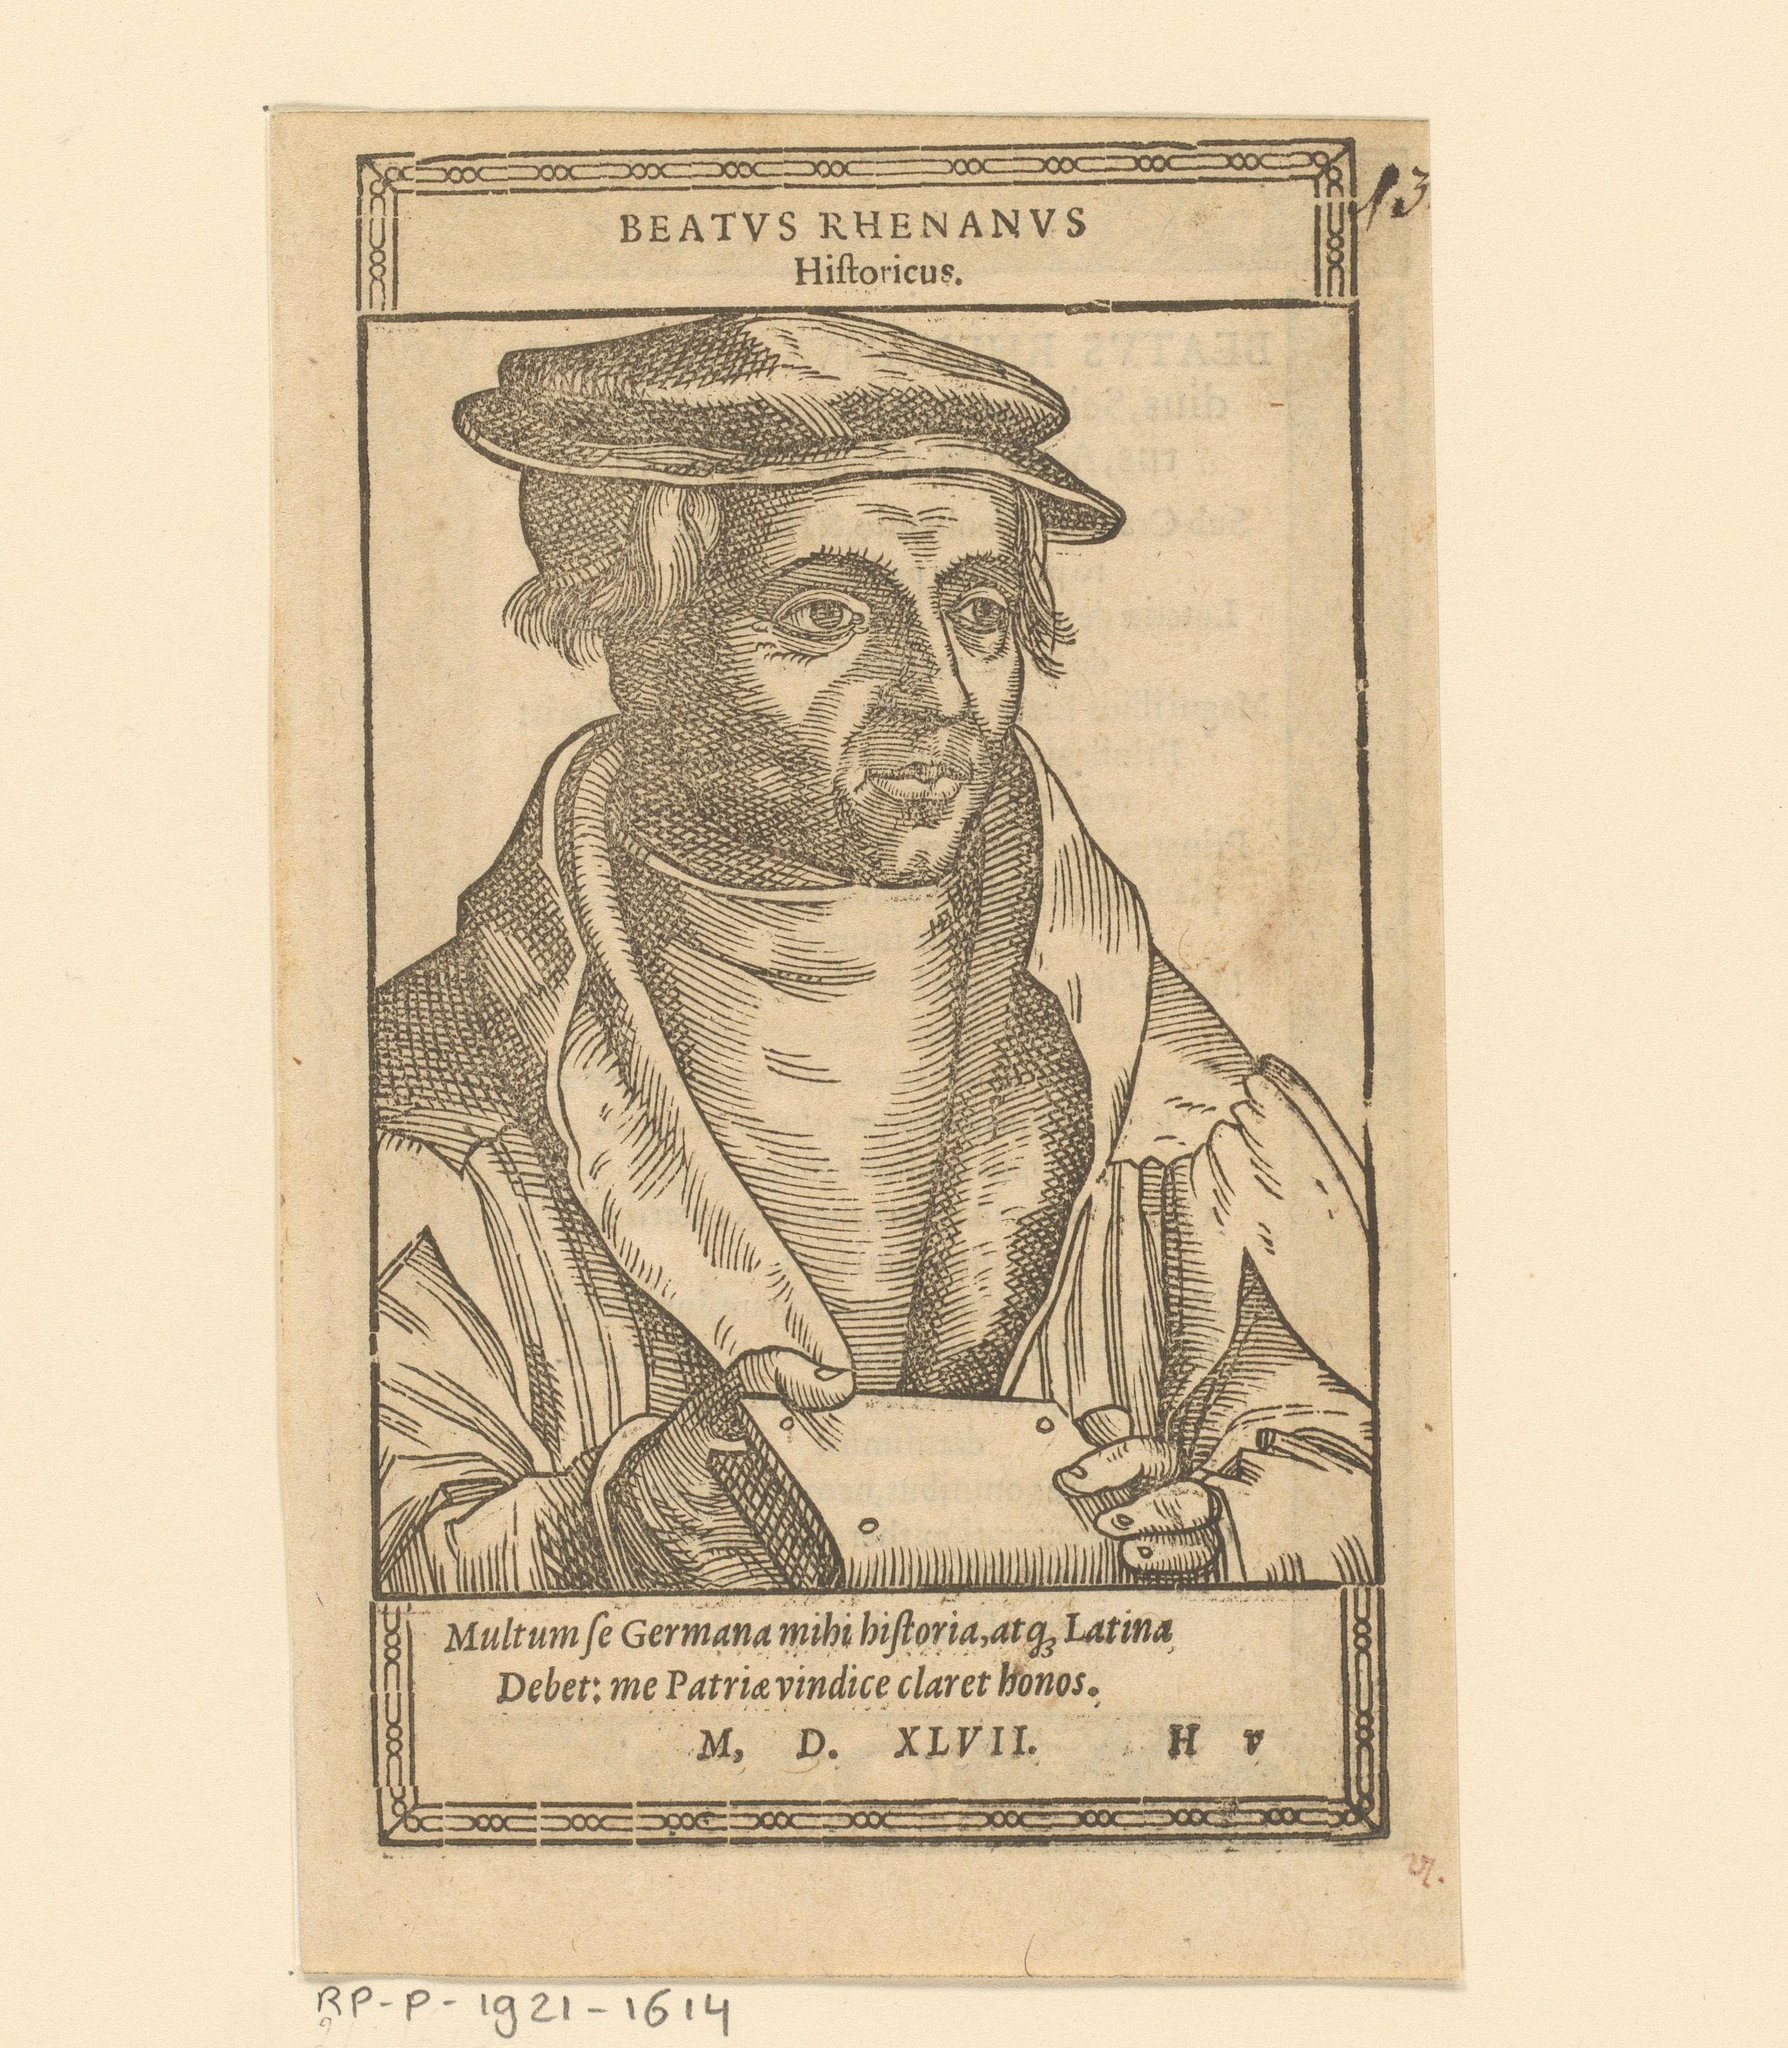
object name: print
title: Portret van Beatus Rhenanus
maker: bernhard jobin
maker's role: printer, publisher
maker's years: 1545-1593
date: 1587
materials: paper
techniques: letterpress printing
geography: straatsburg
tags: historical persons, book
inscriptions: collector's mark: Lugt 2233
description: Prent uit: Reusner, Nikolaus. Icones sive imagines virorum literis illustrium (...). Straatsburg: Bernhard Jobin, 1587. Prent ook gebruikt in de Duitse editie, uitgegeven in hetzelfde jaar, en de 1590-editie. Prent ook gebruikt in latere publicaties.